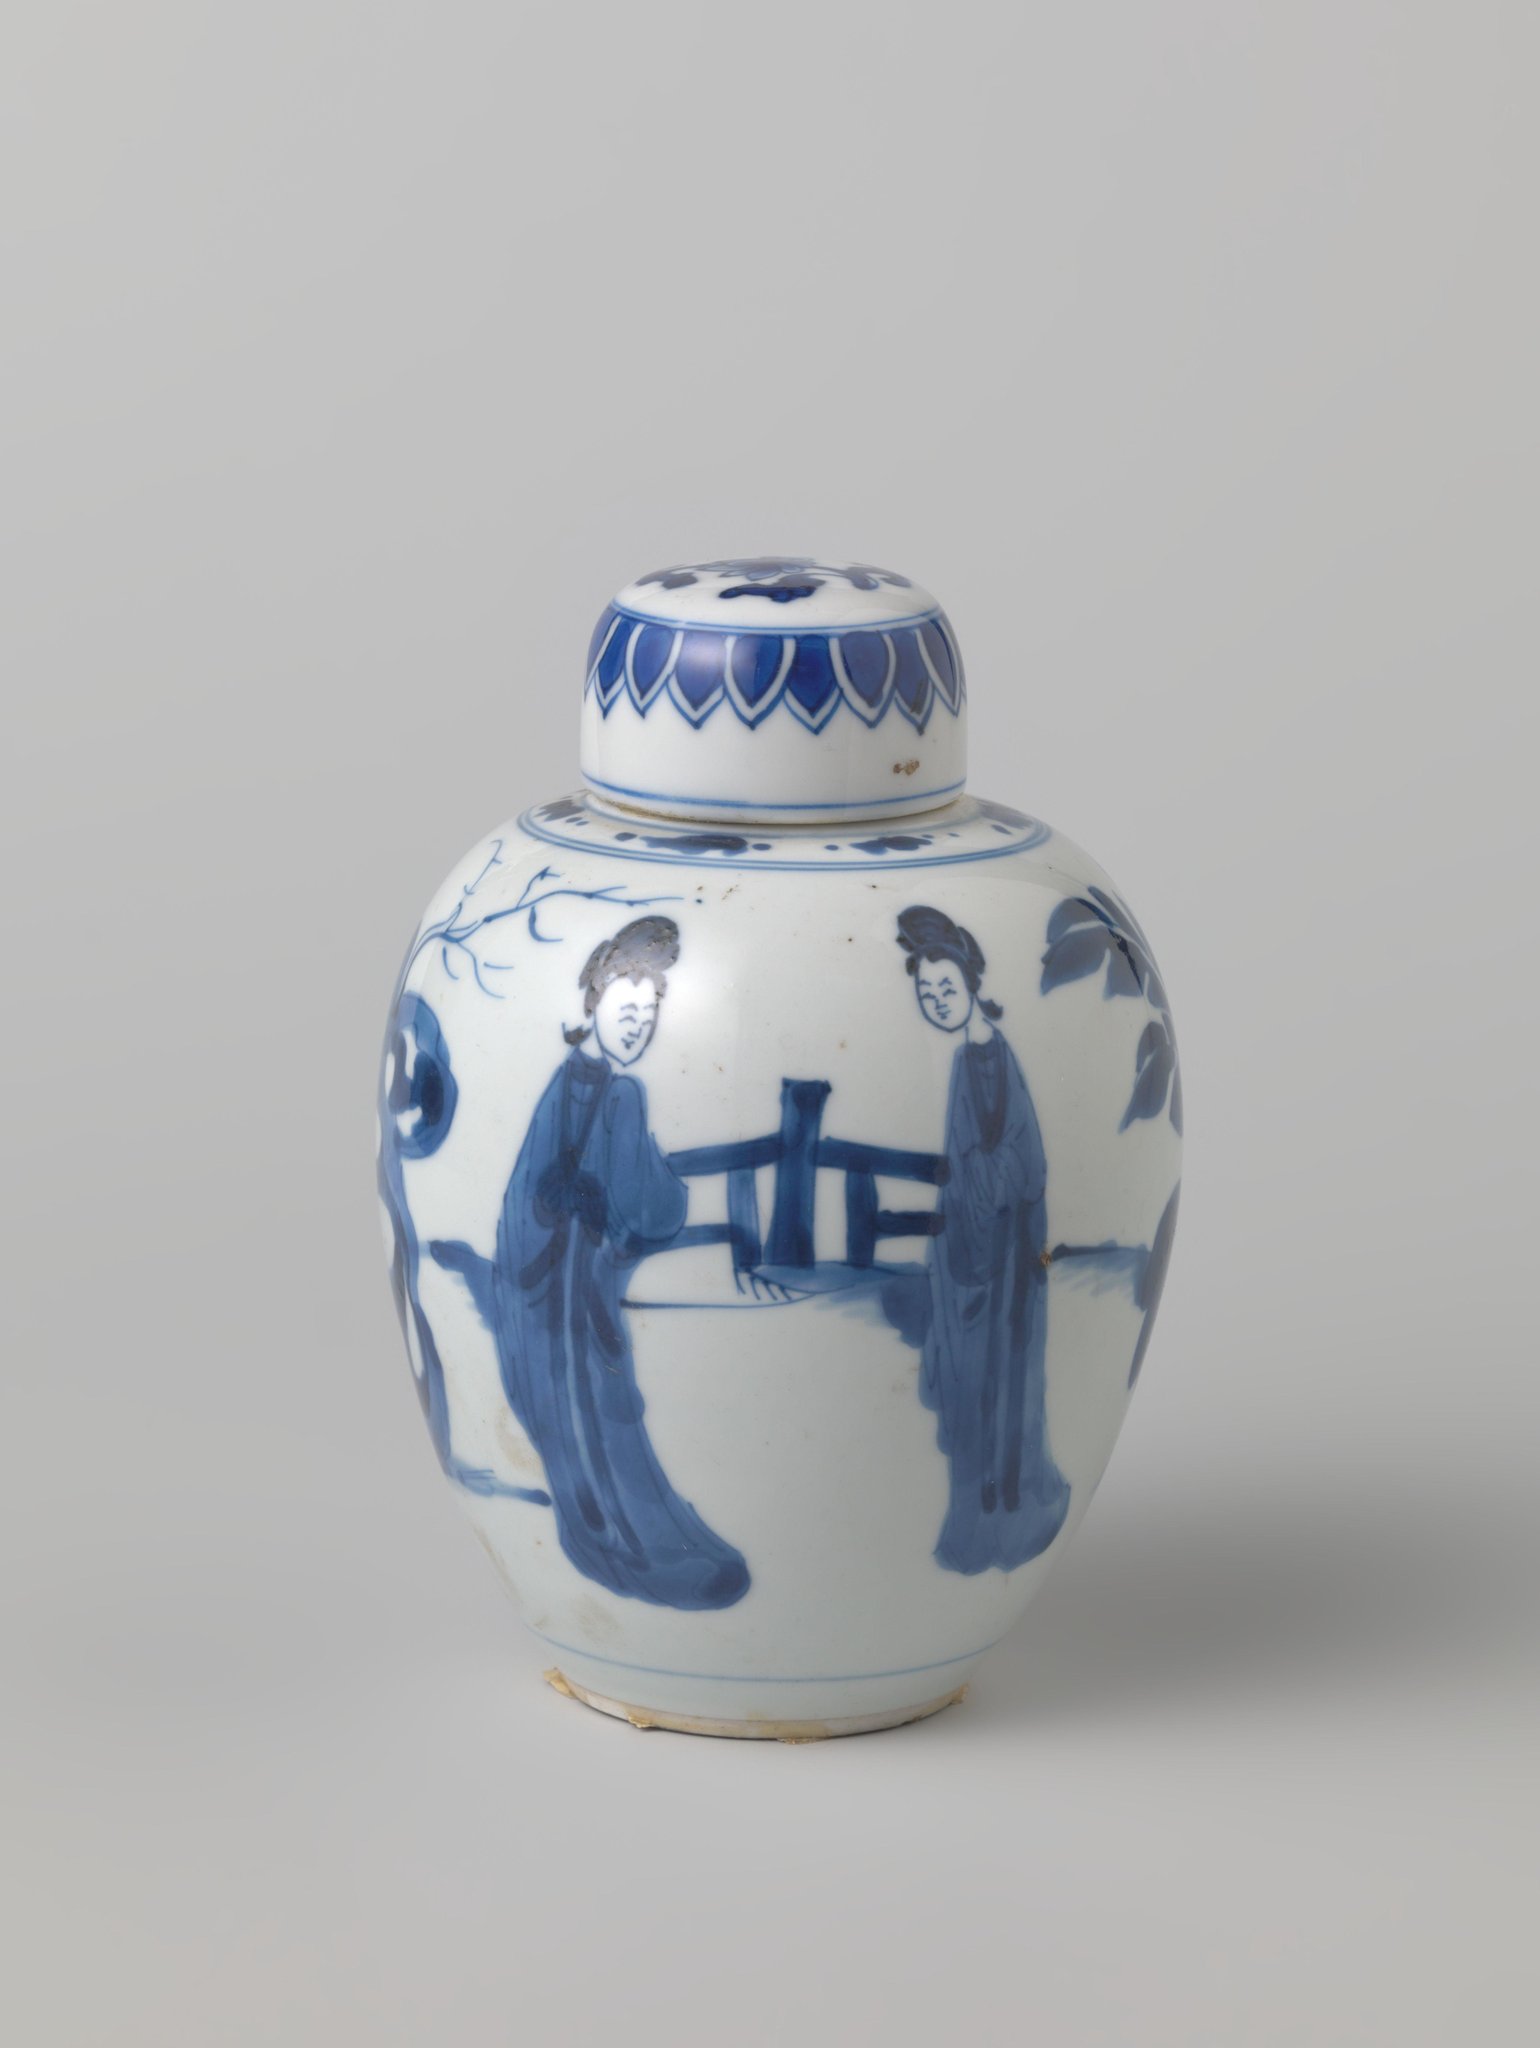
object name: covered jar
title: Ovoid covered jar with four women in a fenced garden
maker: Anonymous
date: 1700-1724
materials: cobalt, glaze, paint, porcelain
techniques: firing, turning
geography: china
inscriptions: mark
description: Eivormige dekselpot van porselein, beschilderd in onderglazuur blauw. Op de wand tweemaal twee vrouwen (lange lijzen) in een omheinde tuin, gescheiden door een rots en een bananenplant. Op de schouder een decoratieve band. De deksel met een lotusrank en een band met afhangende, puntige bladmotieven. Gemerkt op de onderzijde met een artemisiablad. Deksel is verlijmd. Blauw-wit.